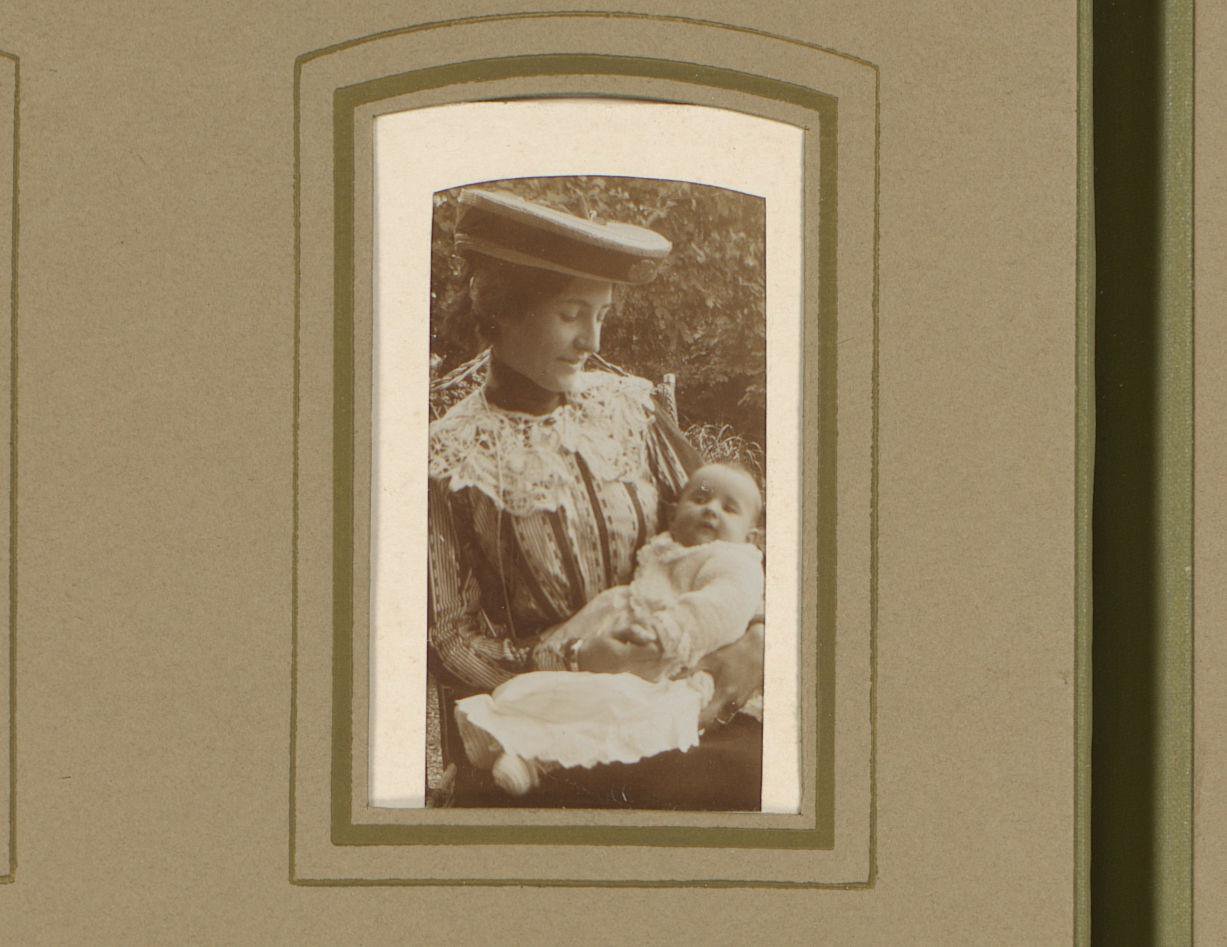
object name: carte de visite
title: Portret van een vrouw met een baby op schoot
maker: Anonymous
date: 1880-1940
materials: cardboard, photographic support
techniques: collodion silver print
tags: historical persons - bb - woman, infant, baby ~ the ages of man